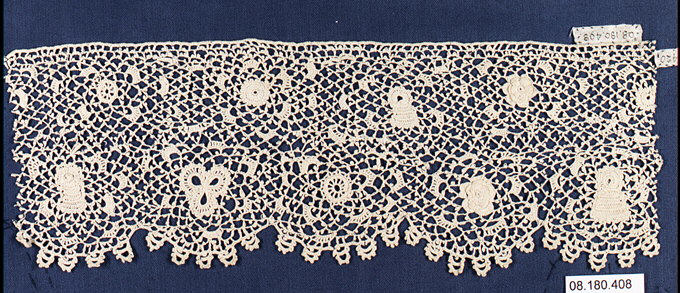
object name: fragment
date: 1801-1900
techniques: crochet